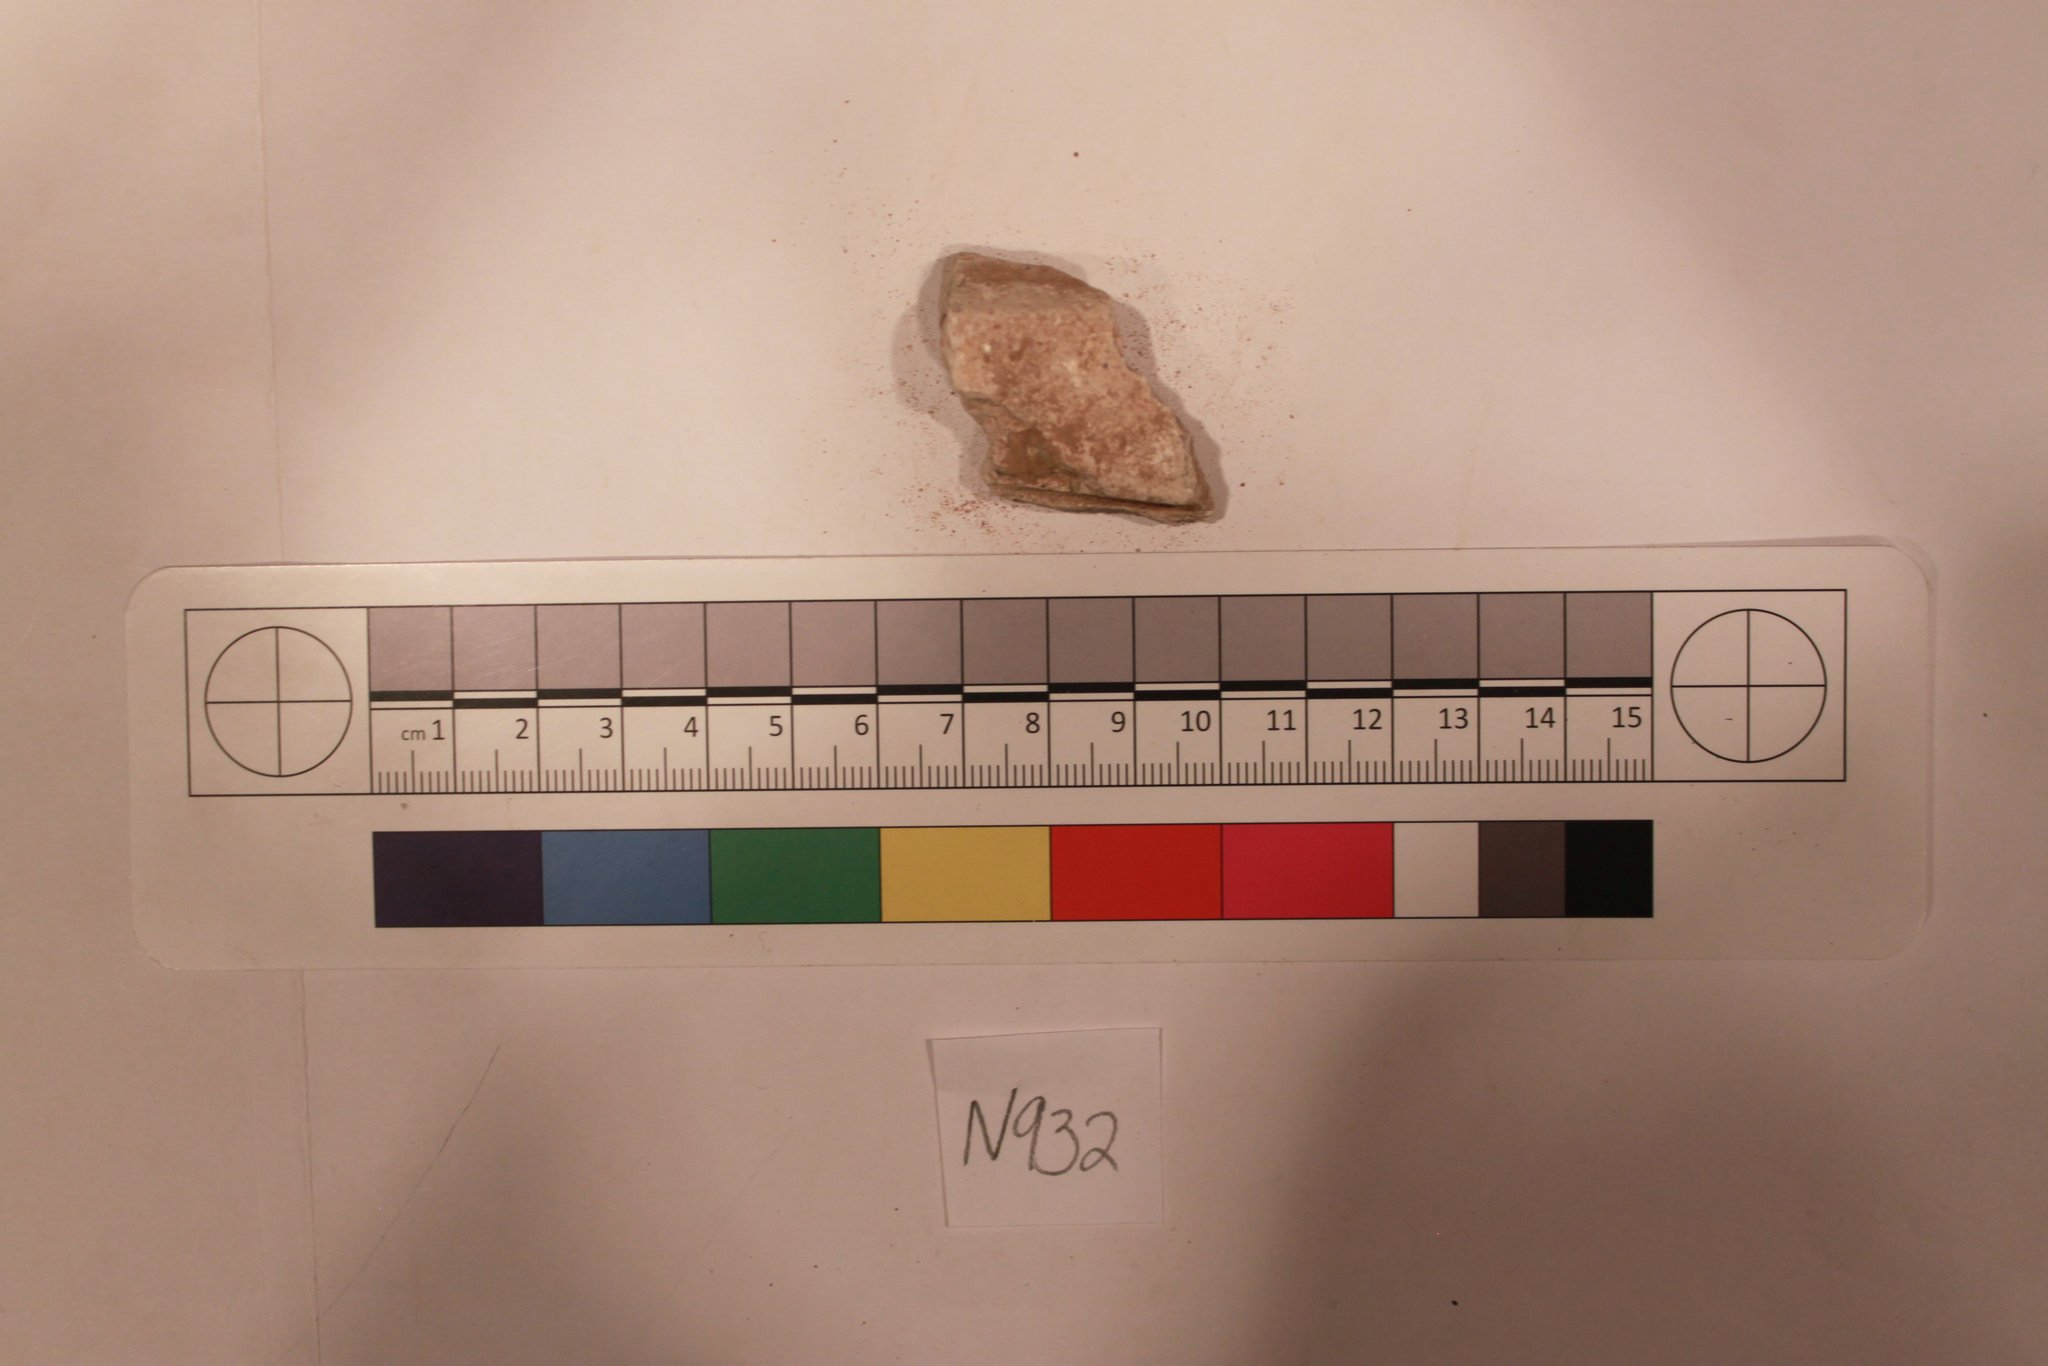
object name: fragment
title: Stucco Fragment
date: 701-1200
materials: plaster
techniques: carving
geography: iran